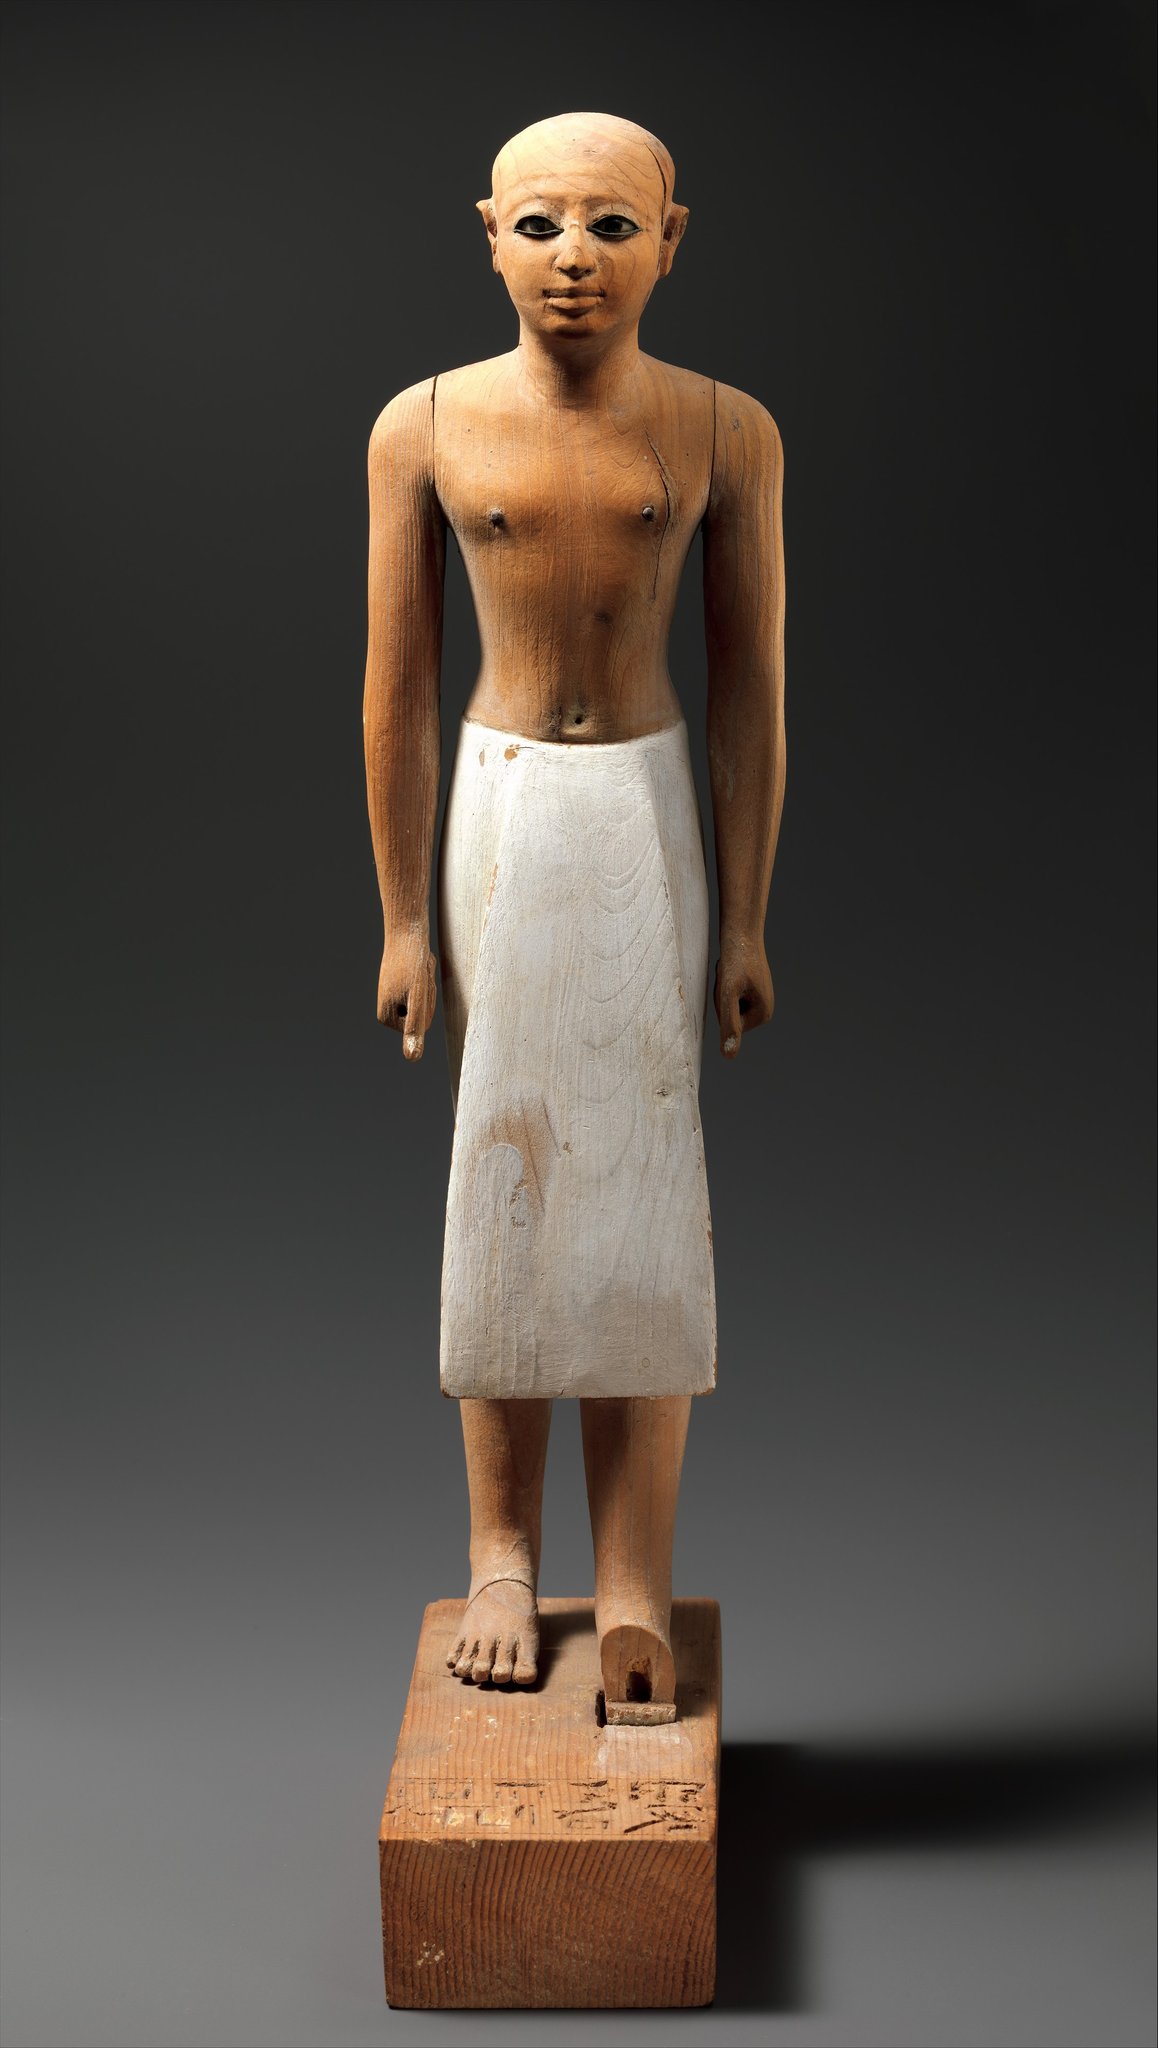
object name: statuette, senbi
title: Statuette of the Steward Senbi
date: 1981-1885 BCE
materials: copper alloy, crystal, paste, wood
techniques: painting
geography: middle egypt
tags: men